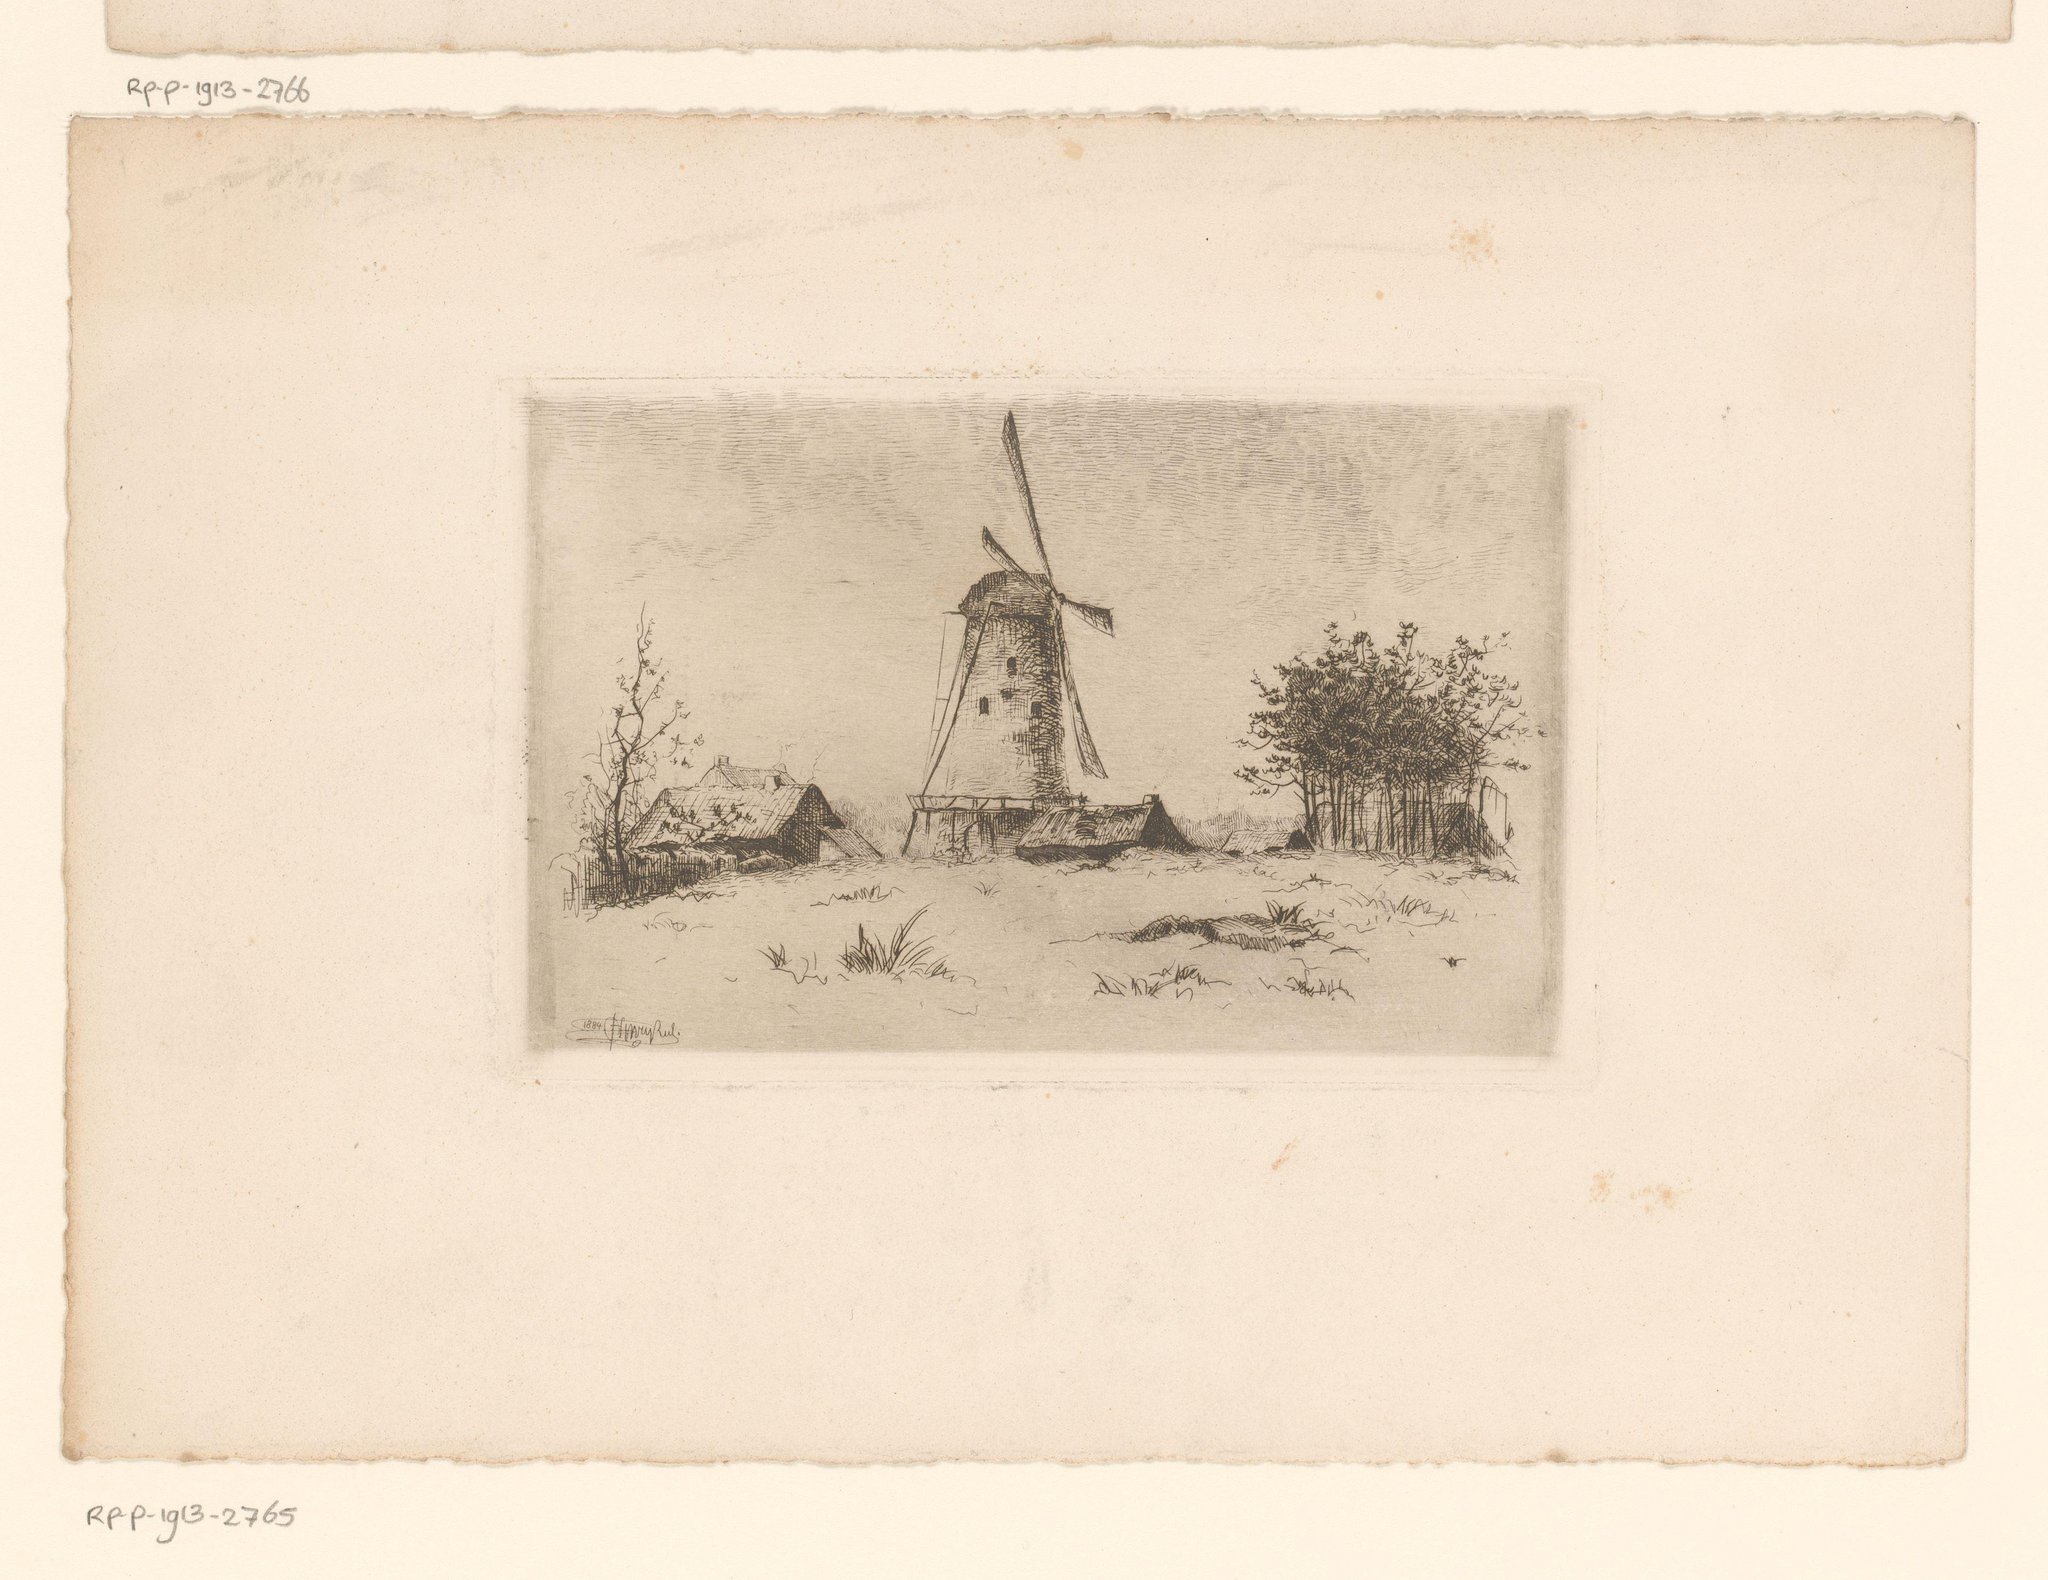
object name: print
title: Landschap met molen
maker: henri rul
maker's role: print maker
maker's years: 1862-1942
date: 1884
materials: paper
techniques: etching, intaglio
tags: windmill in landscape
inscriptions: collector's mark: Lugt 2228